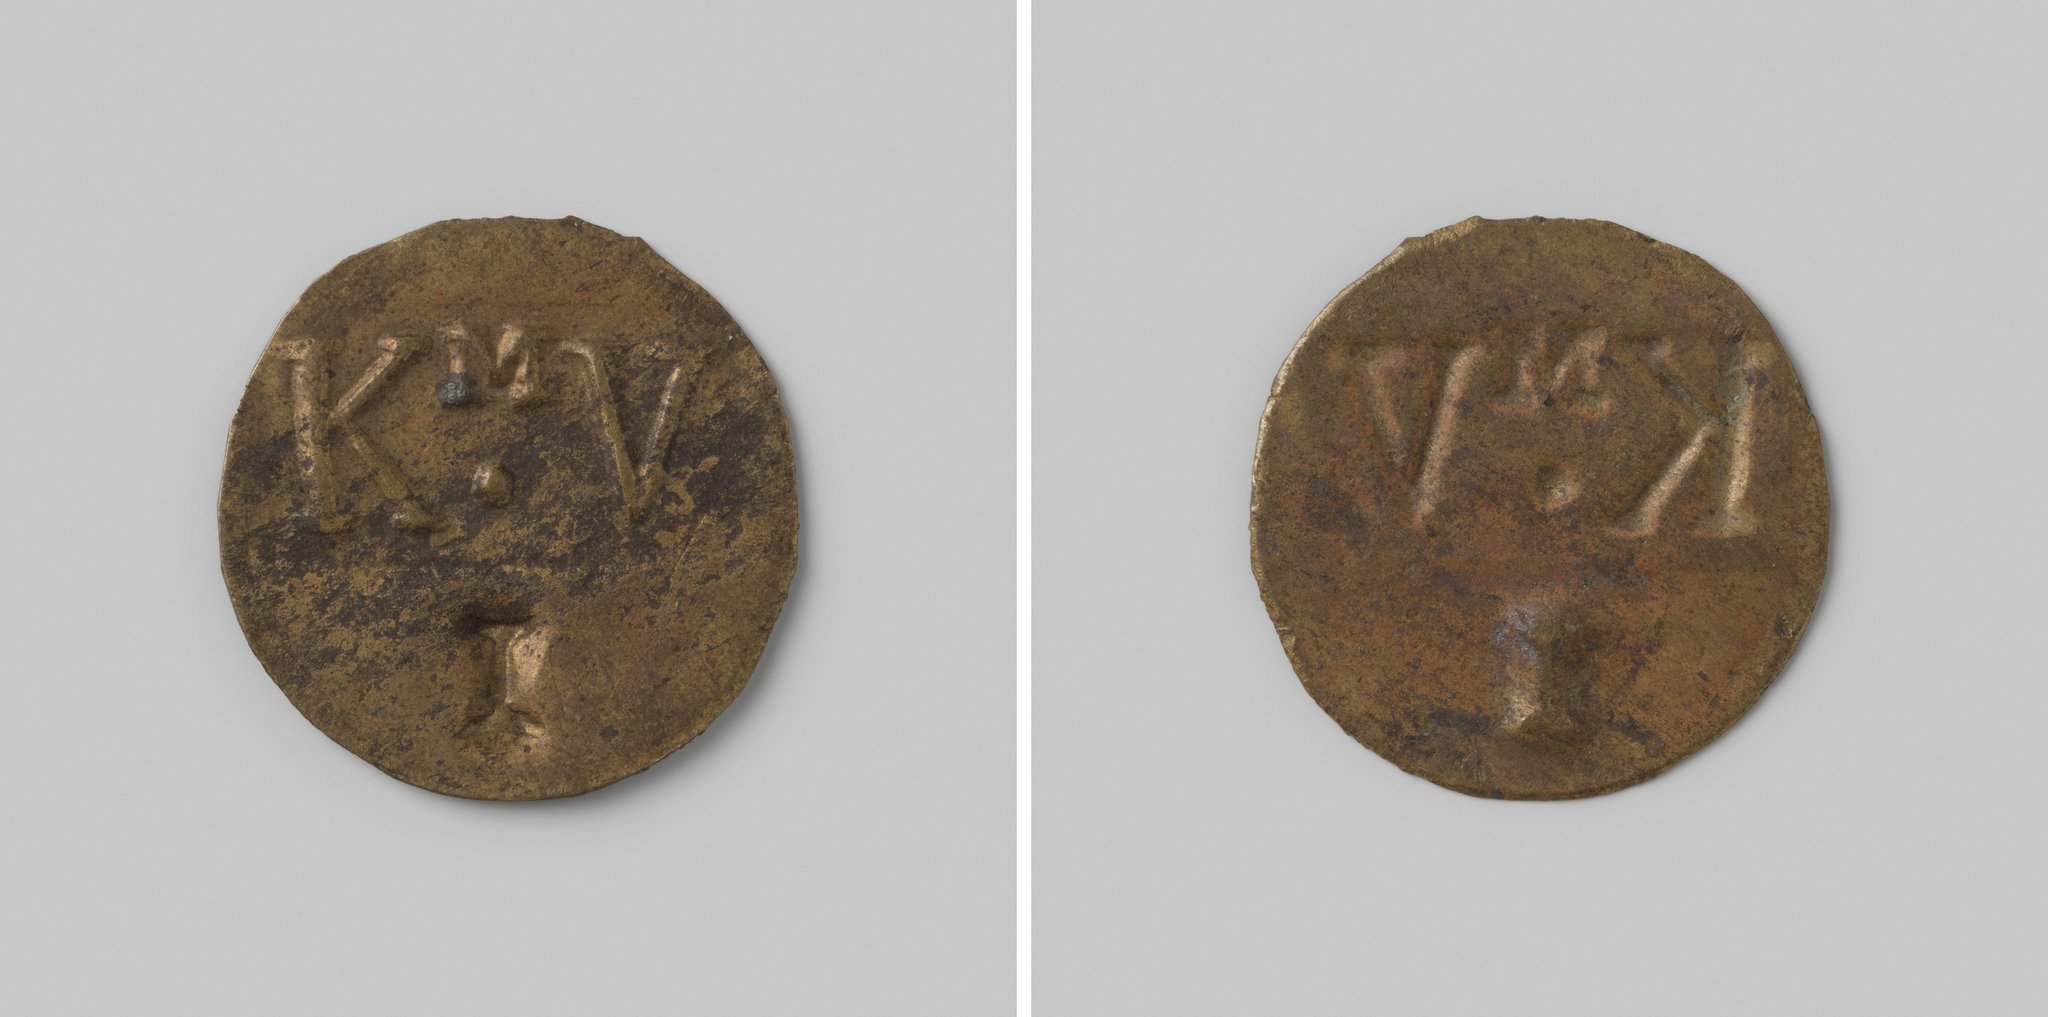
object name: history medal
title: Betaalpenning van 1 cent van de Kolonie Veenhuizen van de Maatschappij van Weldadigheid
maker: Anonymous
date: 1825-1830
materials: brass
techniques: pressing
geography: veenhuizen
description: Rond messing plaatje met ingeperste letters (opwaarts) en cijfer 1 (inwaarts)